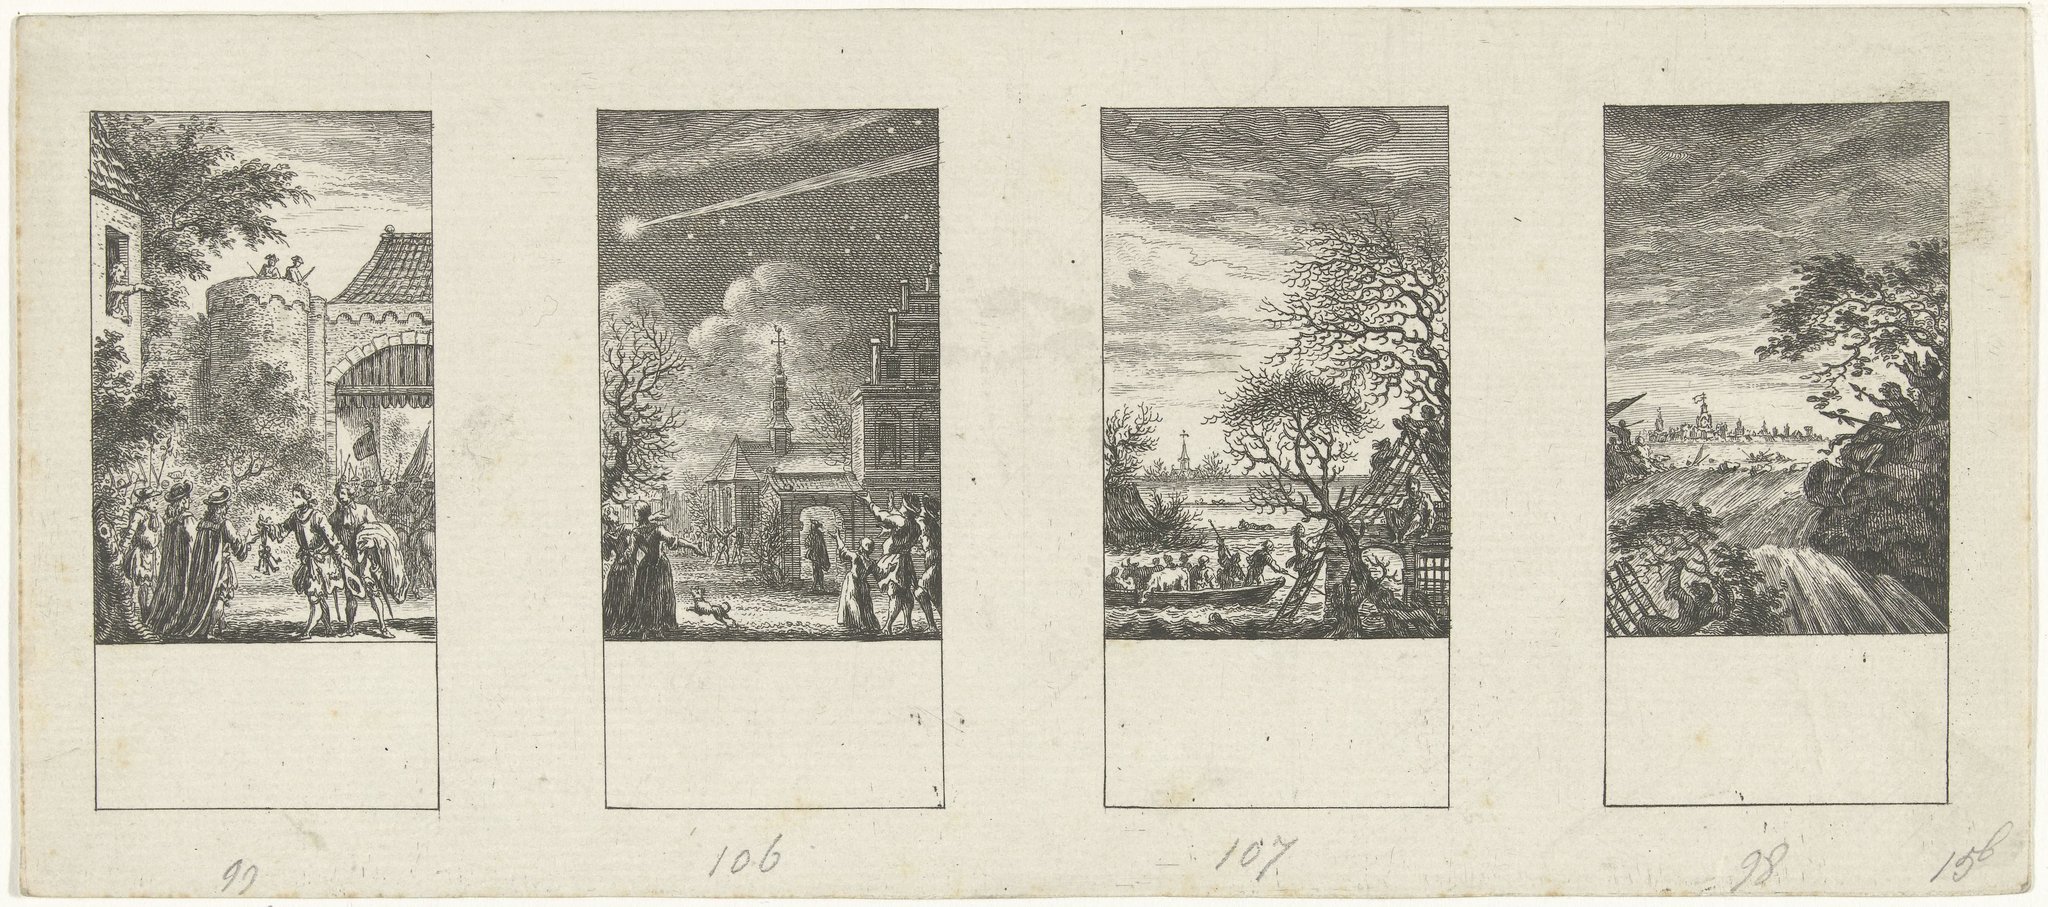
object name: print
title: Illustraties vaderlandse geschiedenis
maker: simon fokke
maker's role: draughtsman, print maker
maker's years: 1712-1784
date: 1722-1784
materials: paper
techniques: etching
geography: amsterdam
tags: historical events and situations, historical persons (portraits and scenes from the life)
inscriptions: number: ‘99, 106, 107, 98’, collector's mark: Lugt 2228